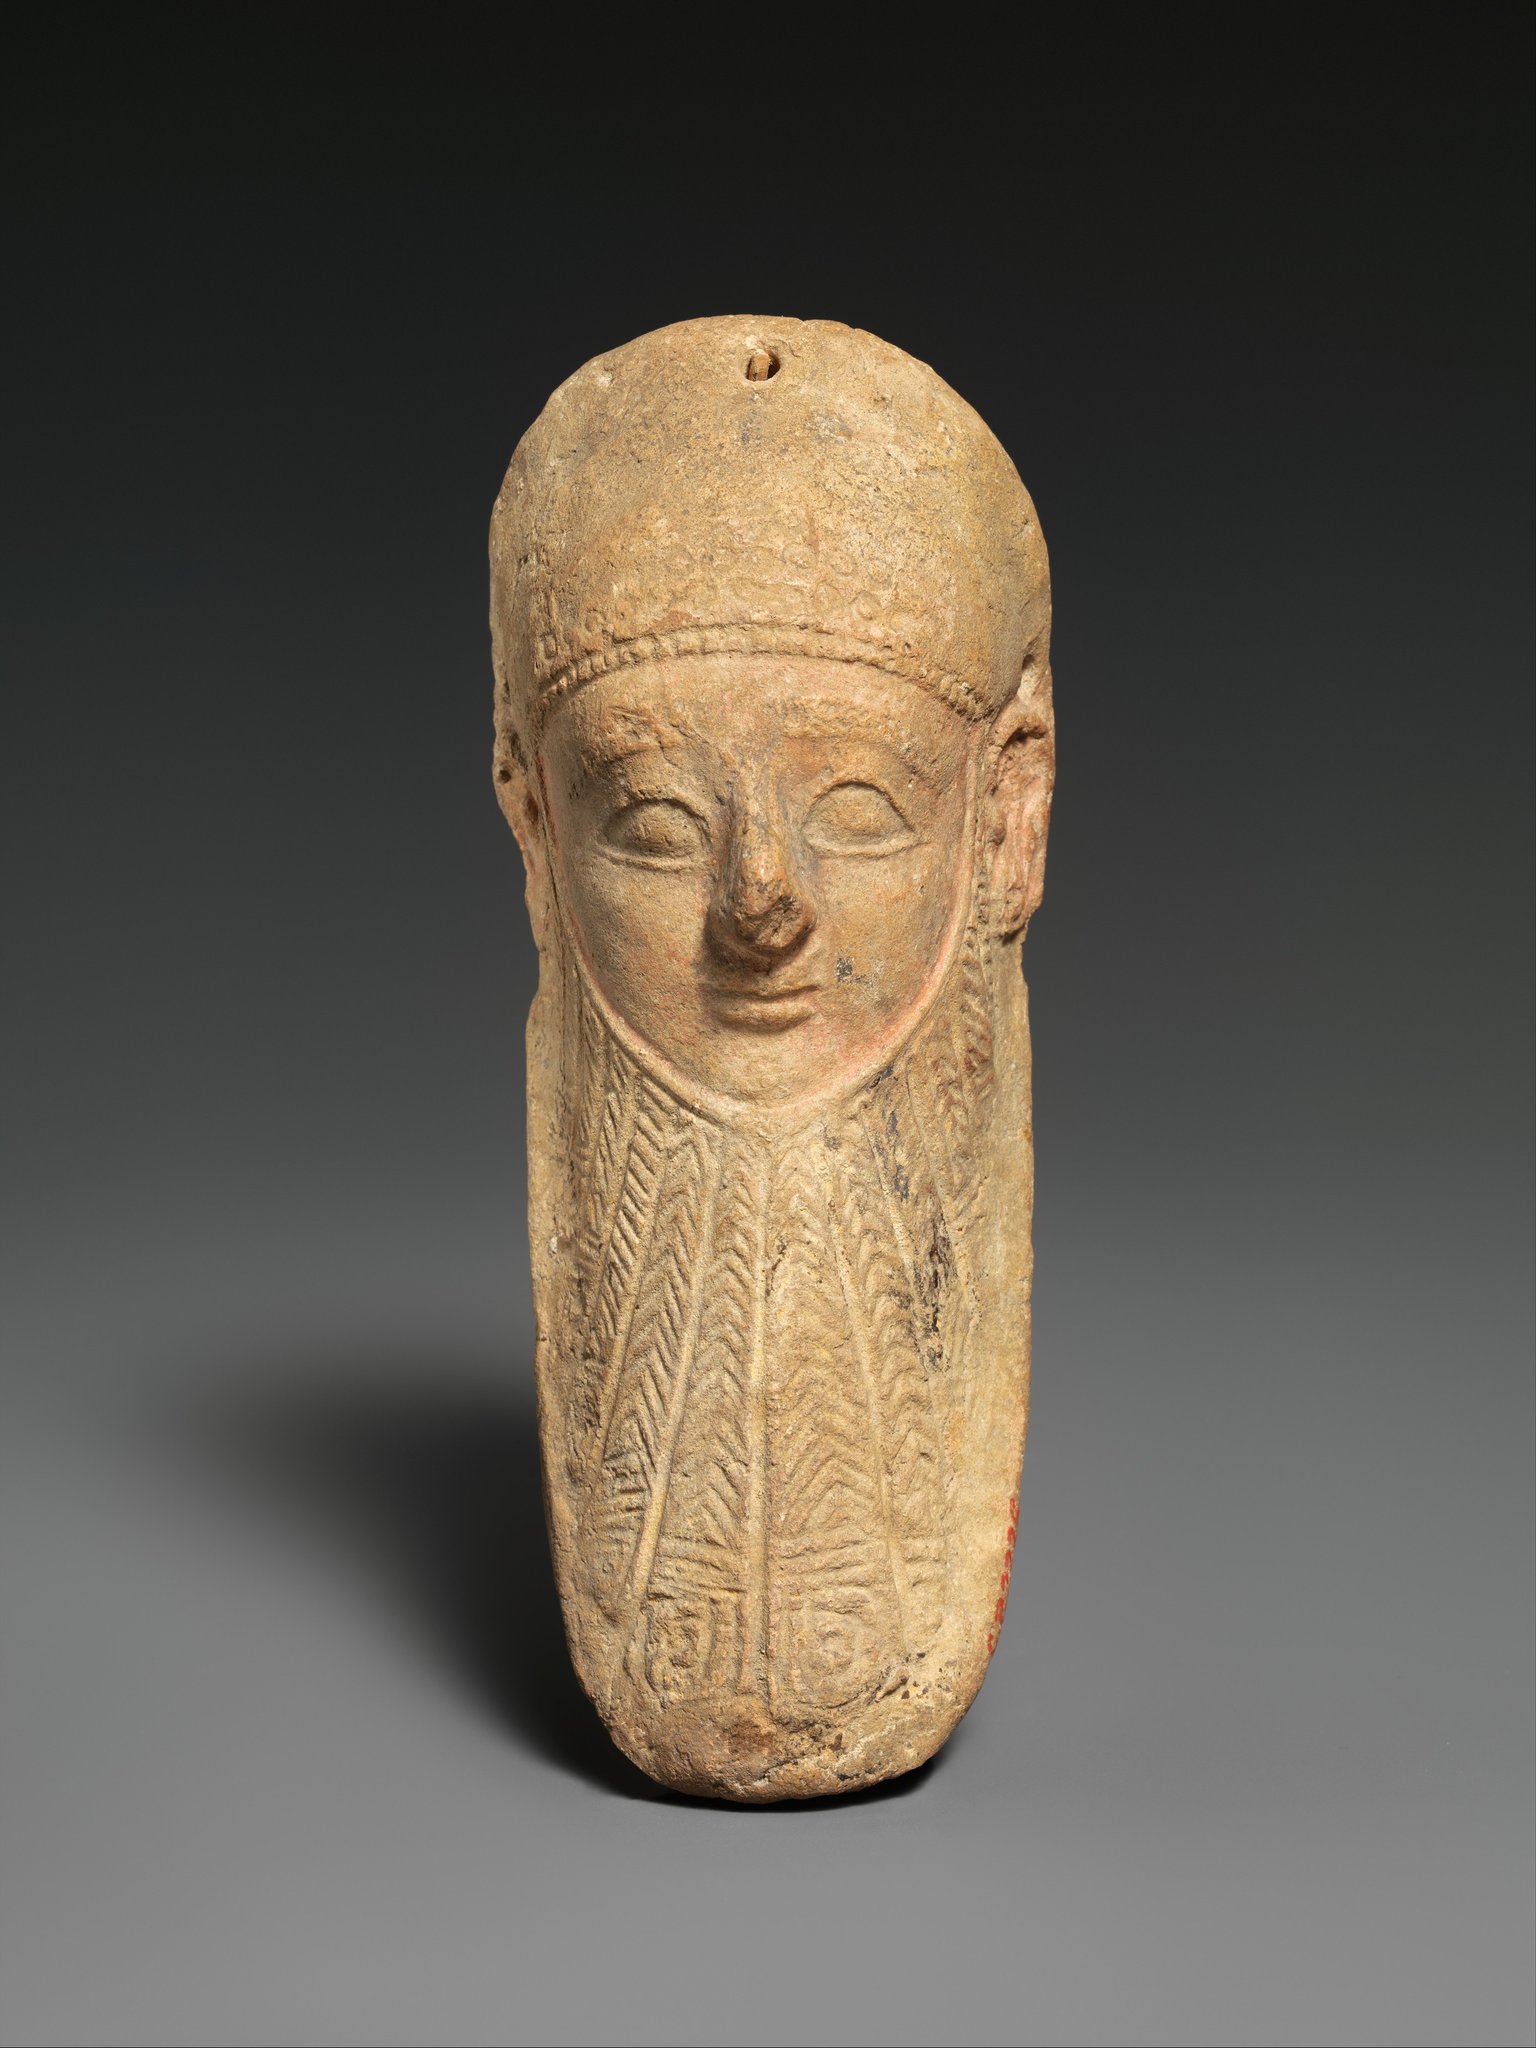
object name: mask of a bearded male head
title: Terracotta mask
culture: cypriot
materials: terracotta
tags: masks